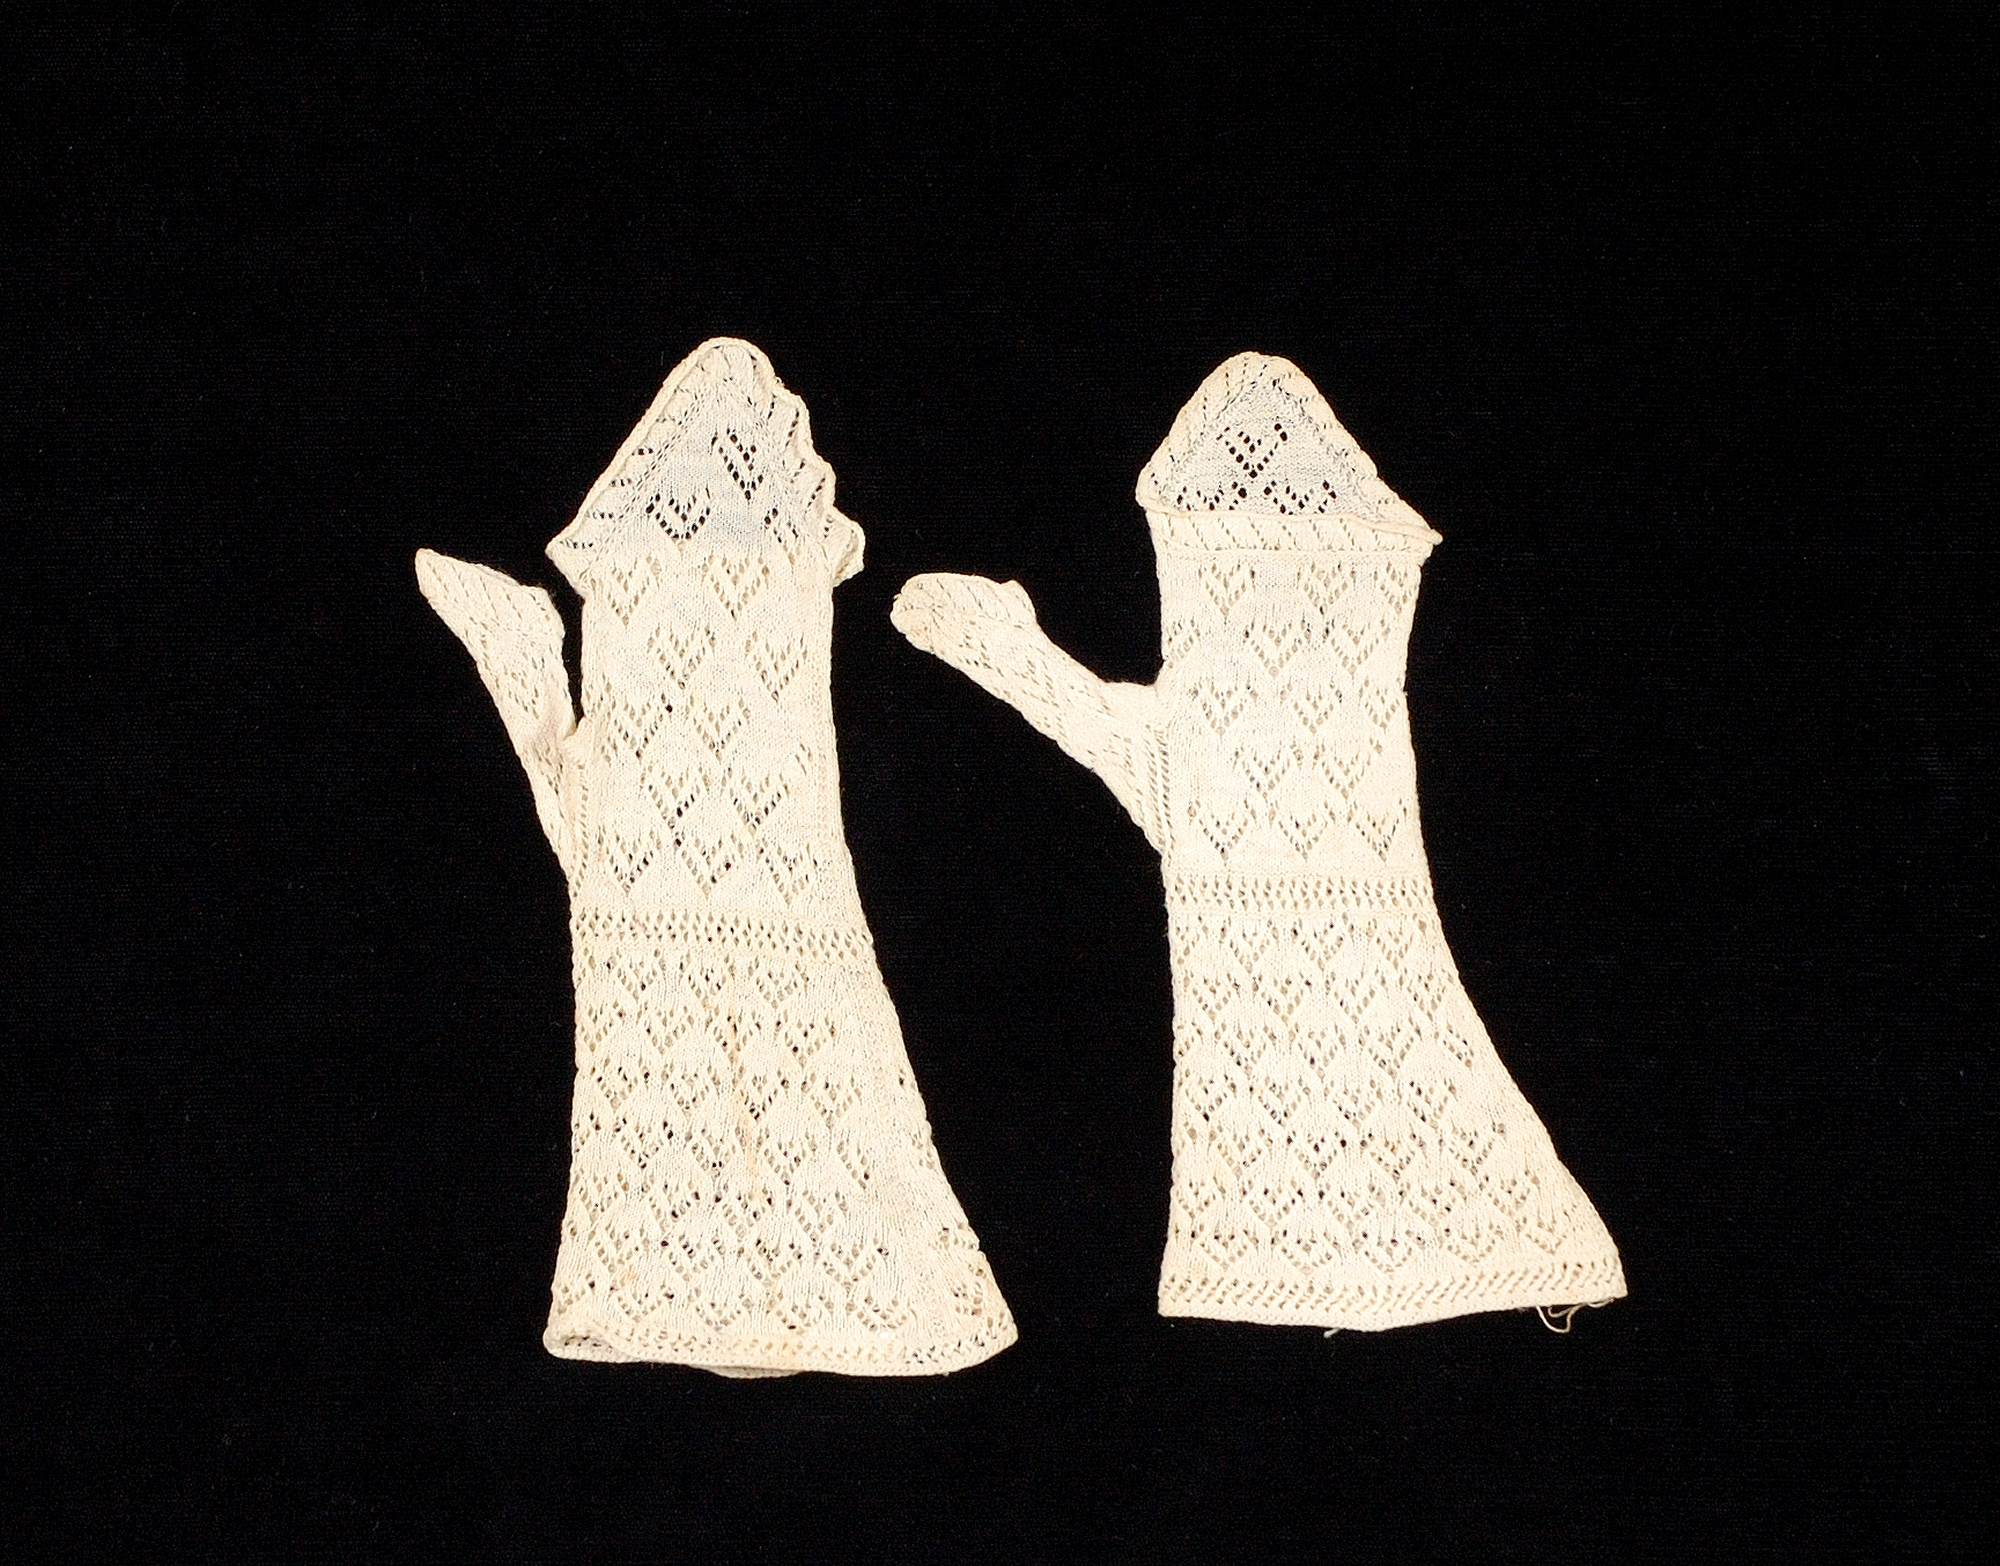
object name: mitt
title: Mitts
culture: american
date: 1830-1835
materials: cotton